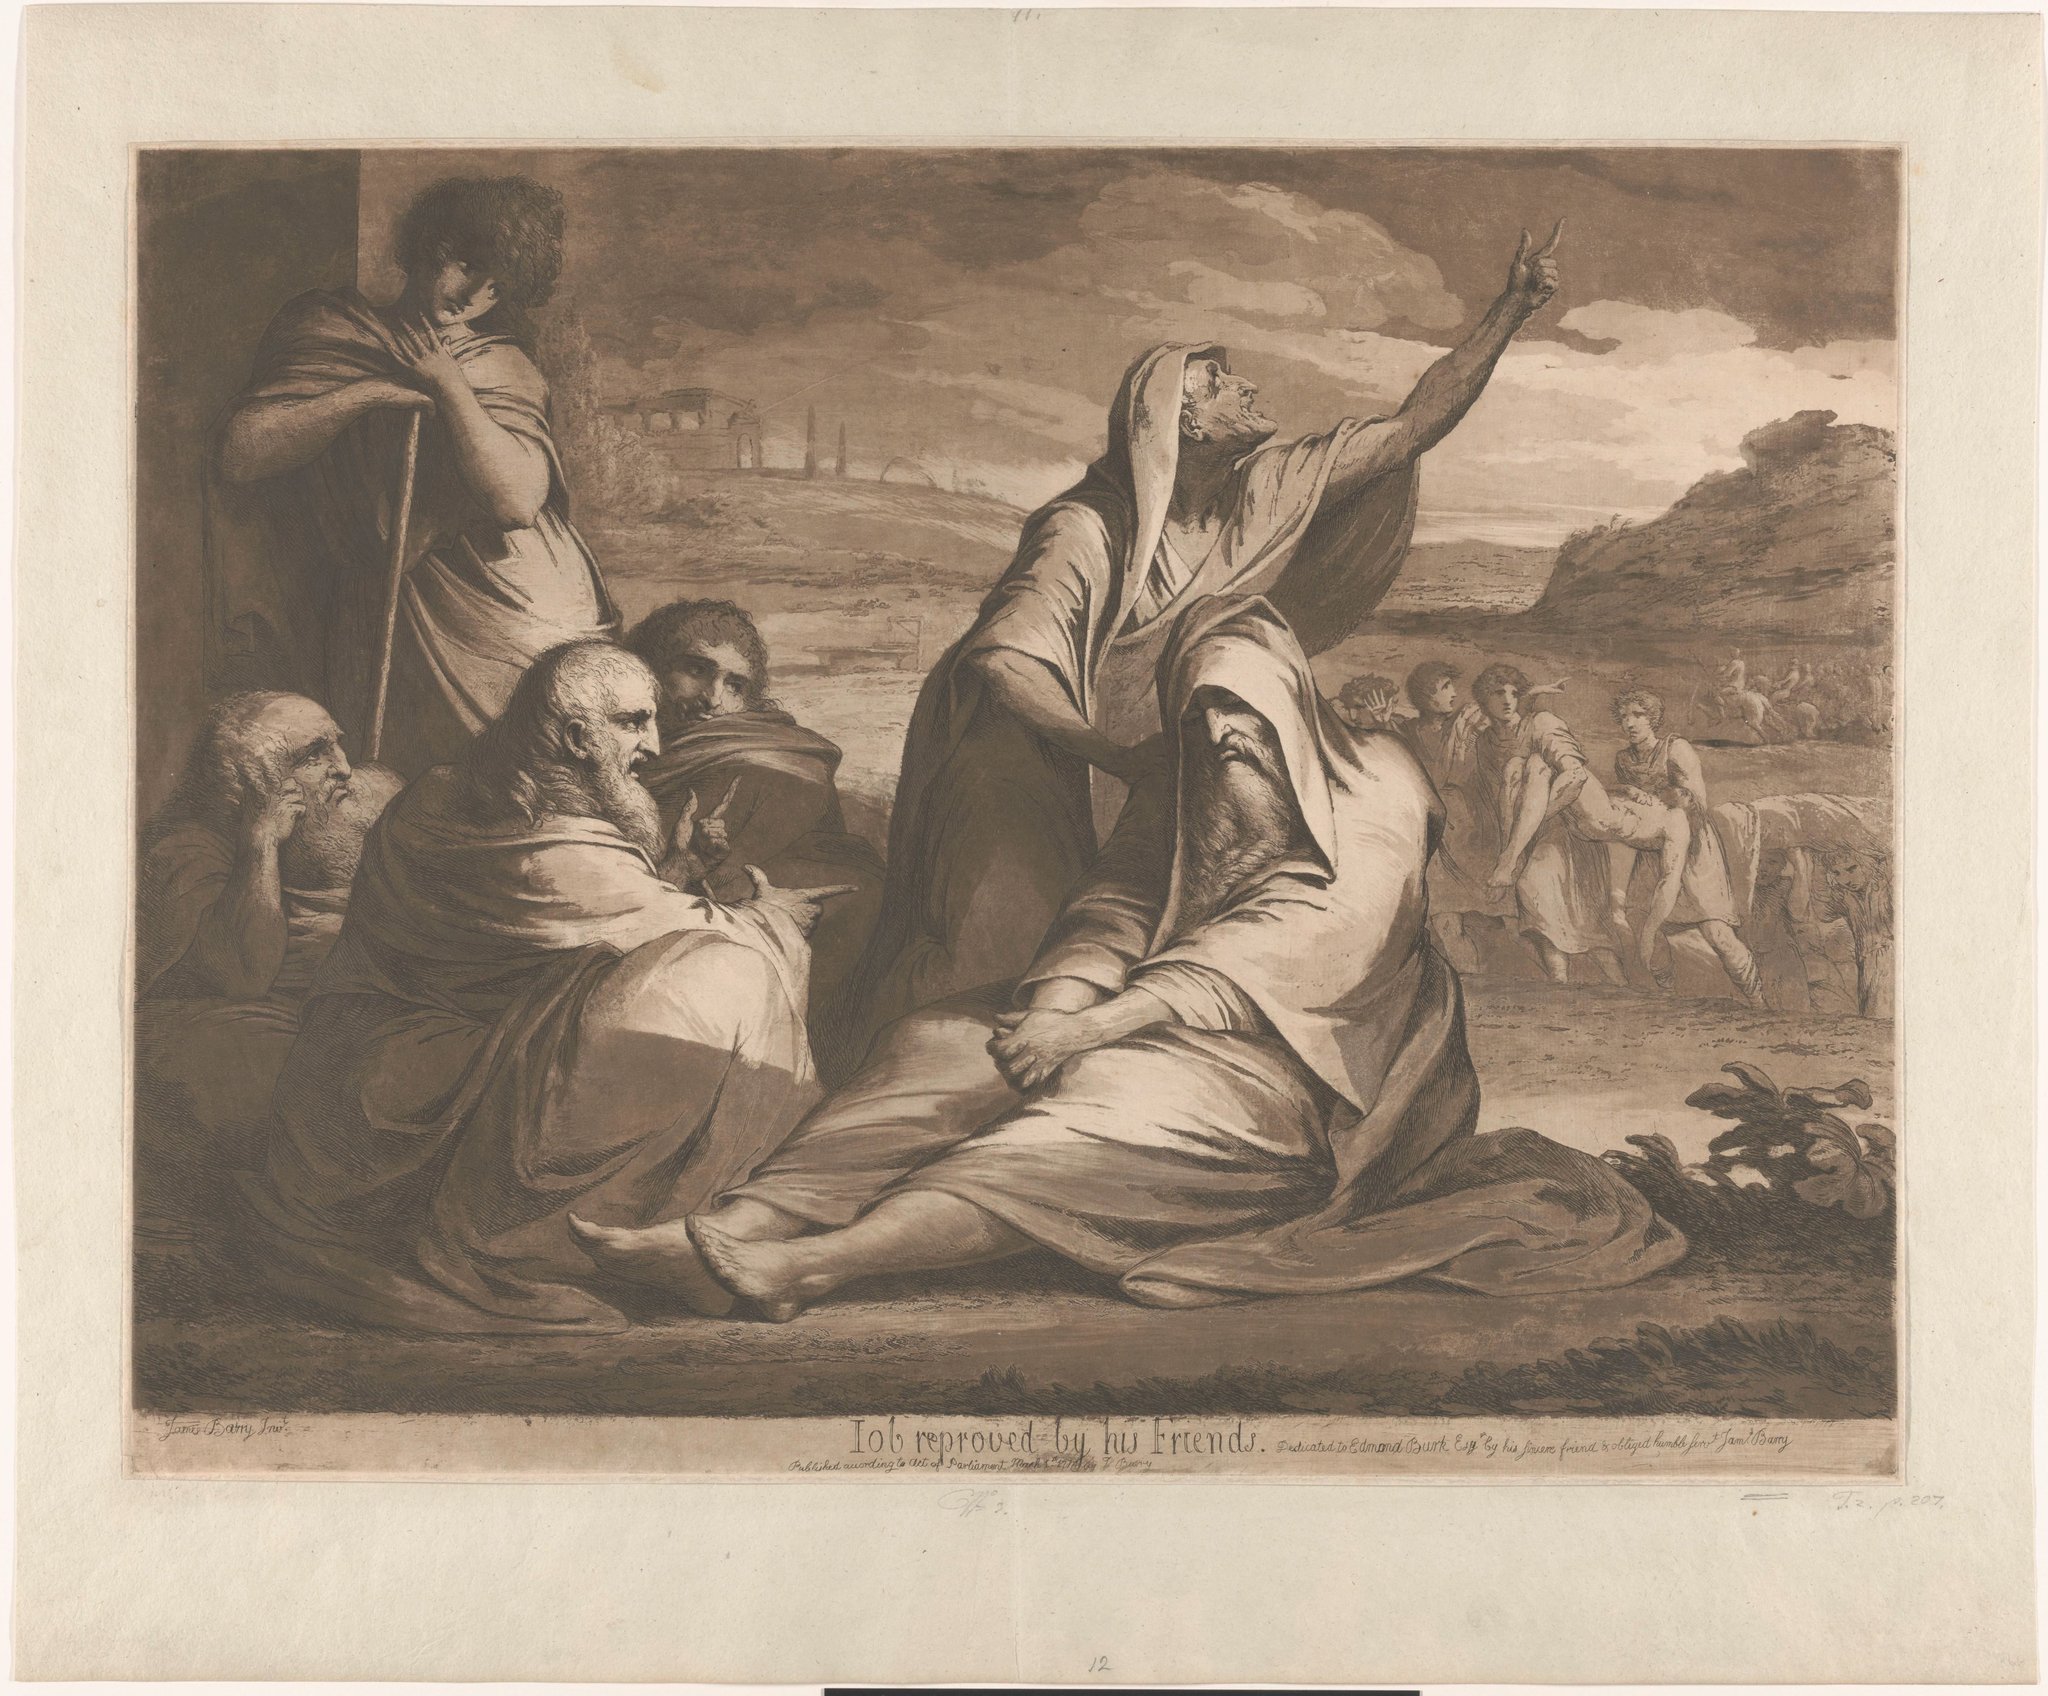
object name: print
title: Job reproved by his friends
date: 1777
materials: paper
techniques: aquatint, etching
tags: politician, edmund burke, the dialogue ~ job discussing with his friends (job 4-31)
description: Behalve een monumentale en ''sublime'' uitbeelding van een oudtestamentisch thema, is de prent eveneens bedoeld als politieke allegorie op de rampzalige staat van Engeland ten tijde van de Amerikaanse revolutie. De geplaagde Job staat voor Albion. Zijn vrouw vertoont de trekken van de politicus en geestverwant van de kunstenaar, William Pitt. De staande figuur links bevat een portret van de kunsttheoreticus Edmund Burke, aan wie de prent is opgedragen.